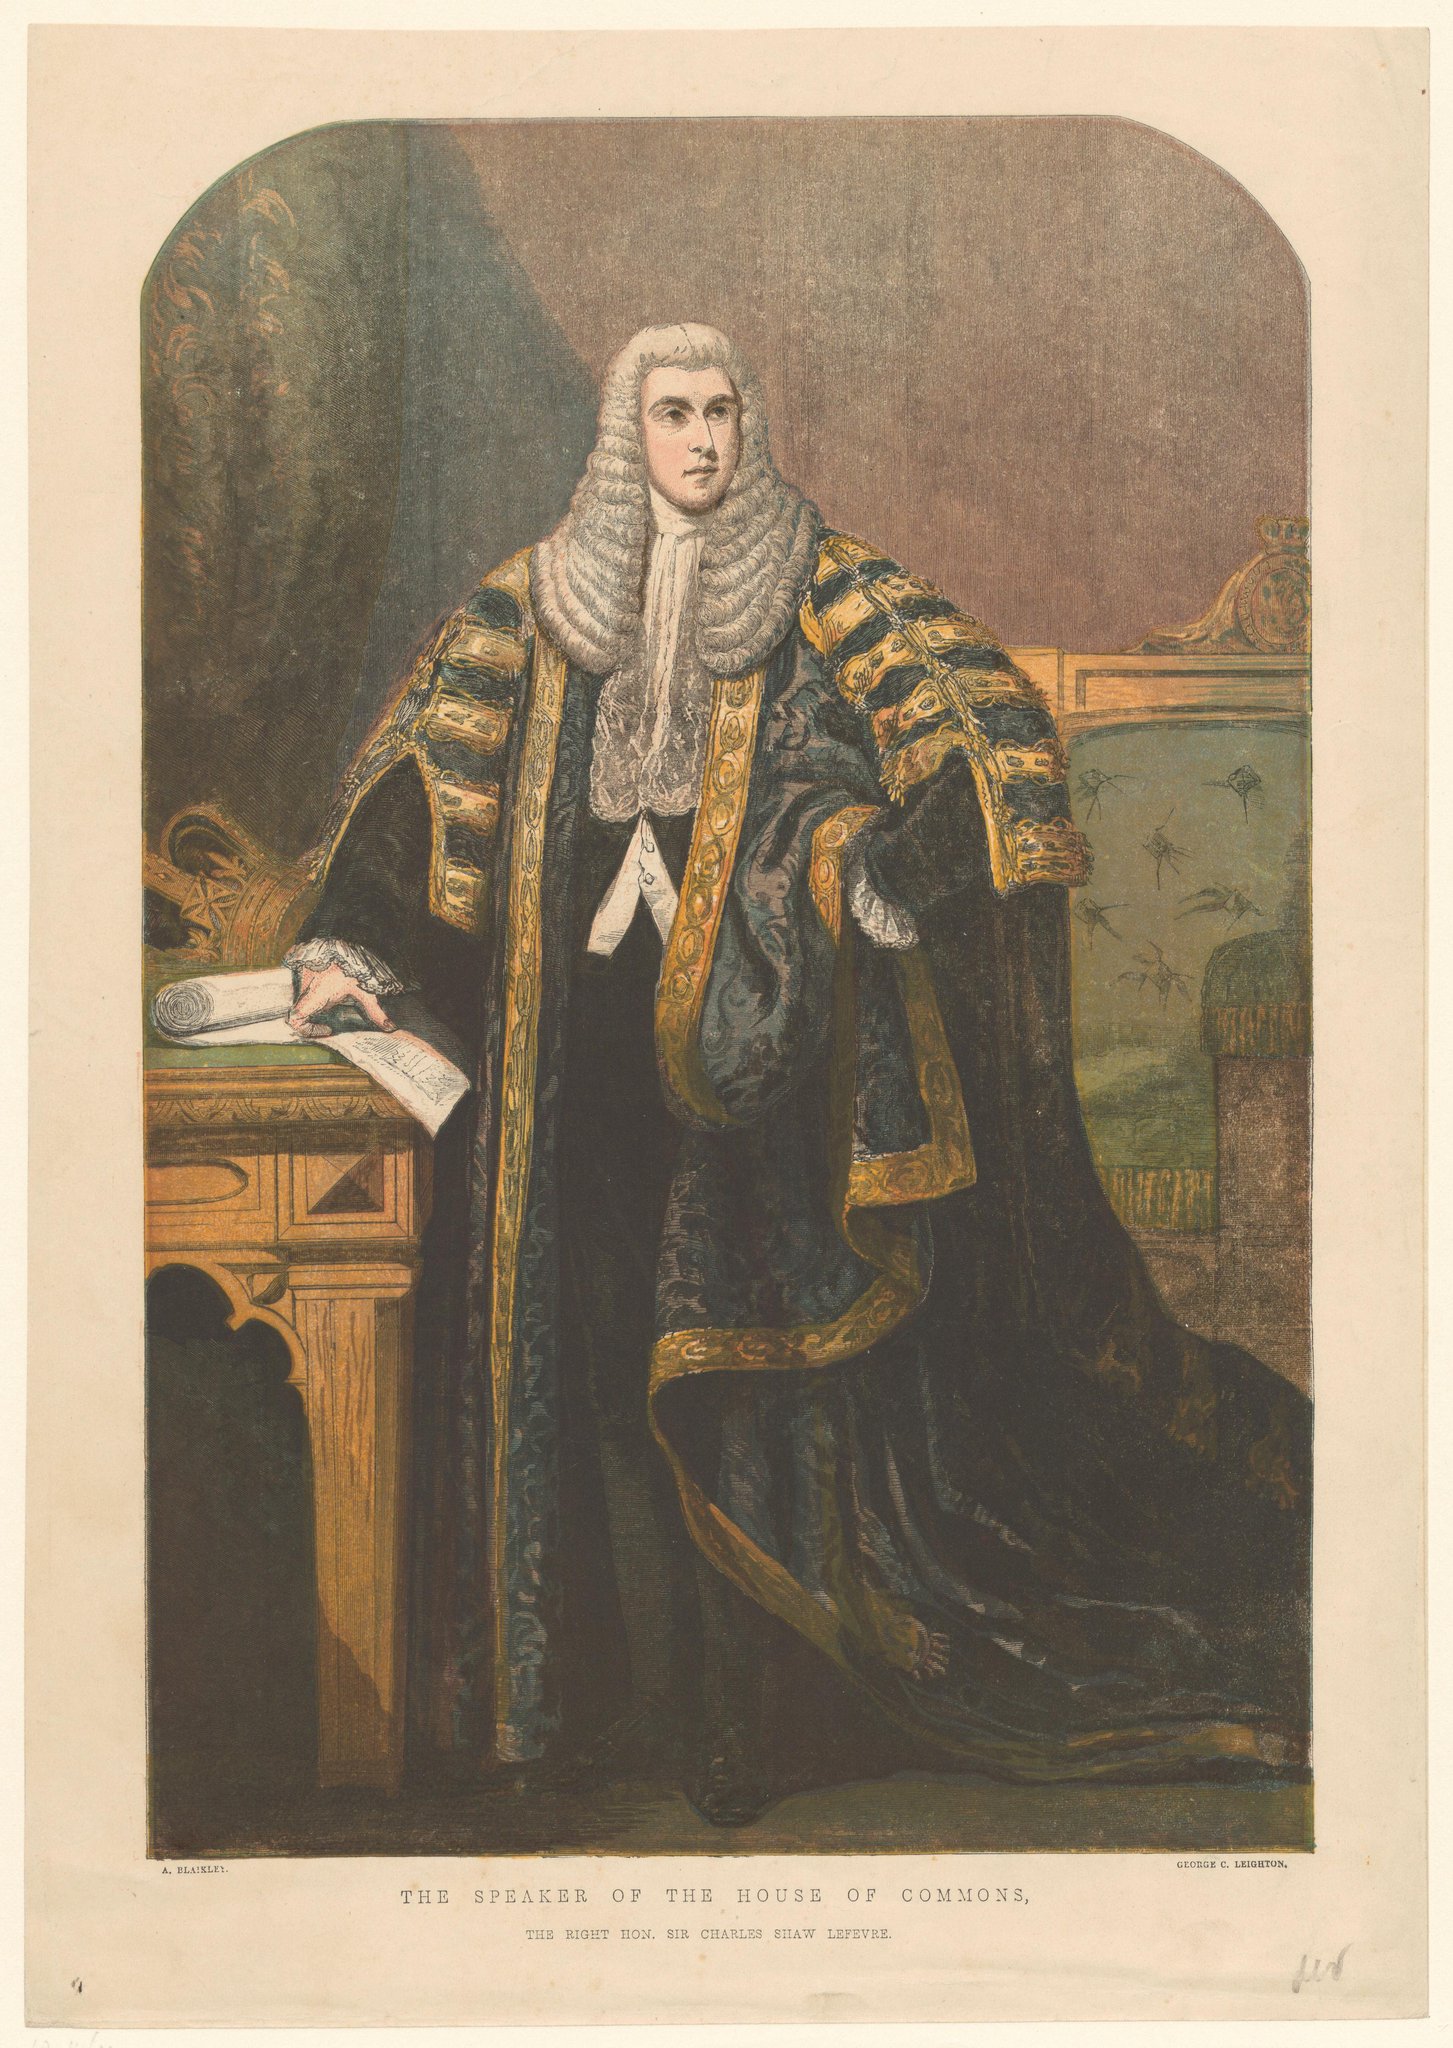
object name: print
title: Portret van sir Charles Shaw-Lefevre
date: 1857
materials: paper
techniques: wood engraving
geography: london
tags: politician, adult man, historical persons, mantle, gown, dress (symbol of sovereignty), scroll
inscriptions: collector's mark: Lugt 2228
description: Prent uit: The Illustrated London News (1857), 7 februari 1857.